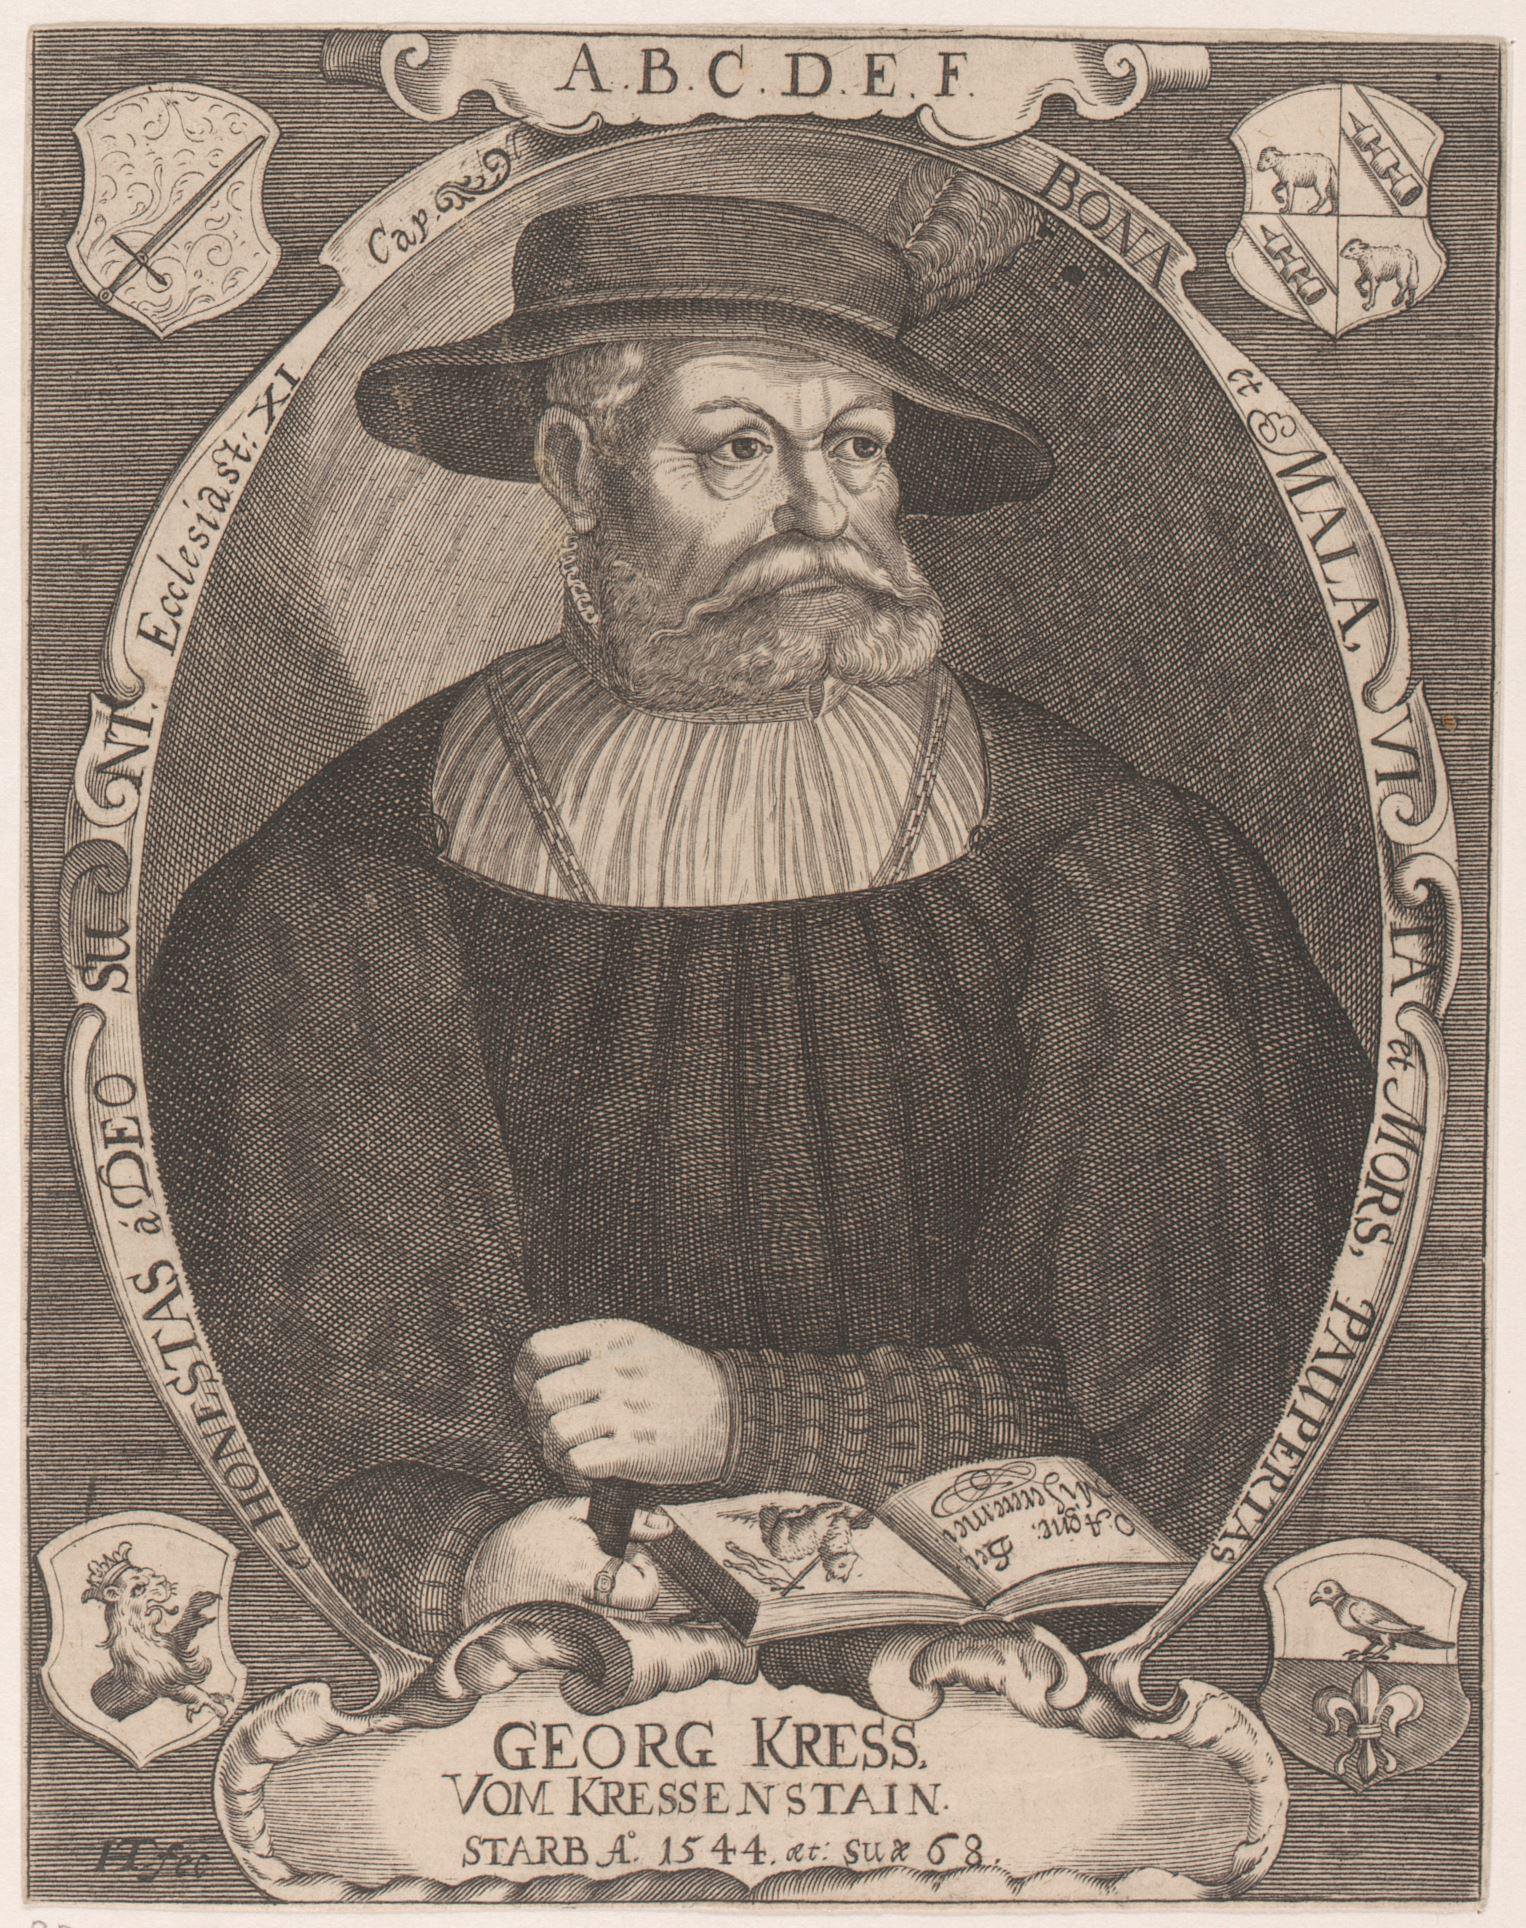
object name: print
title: Portret van Georg Kreß von Kressenstein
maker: hans troschel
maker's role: draughtsman, print maker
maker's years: 1585-1628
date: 1595-1628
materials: paper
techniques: engraving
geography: germany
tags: lamb bearing cross or banner, 'agnus dei' ~ symbol of christ, historical persons, armorial bearing, heraldry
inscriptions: collector's mark: Lugt 2228